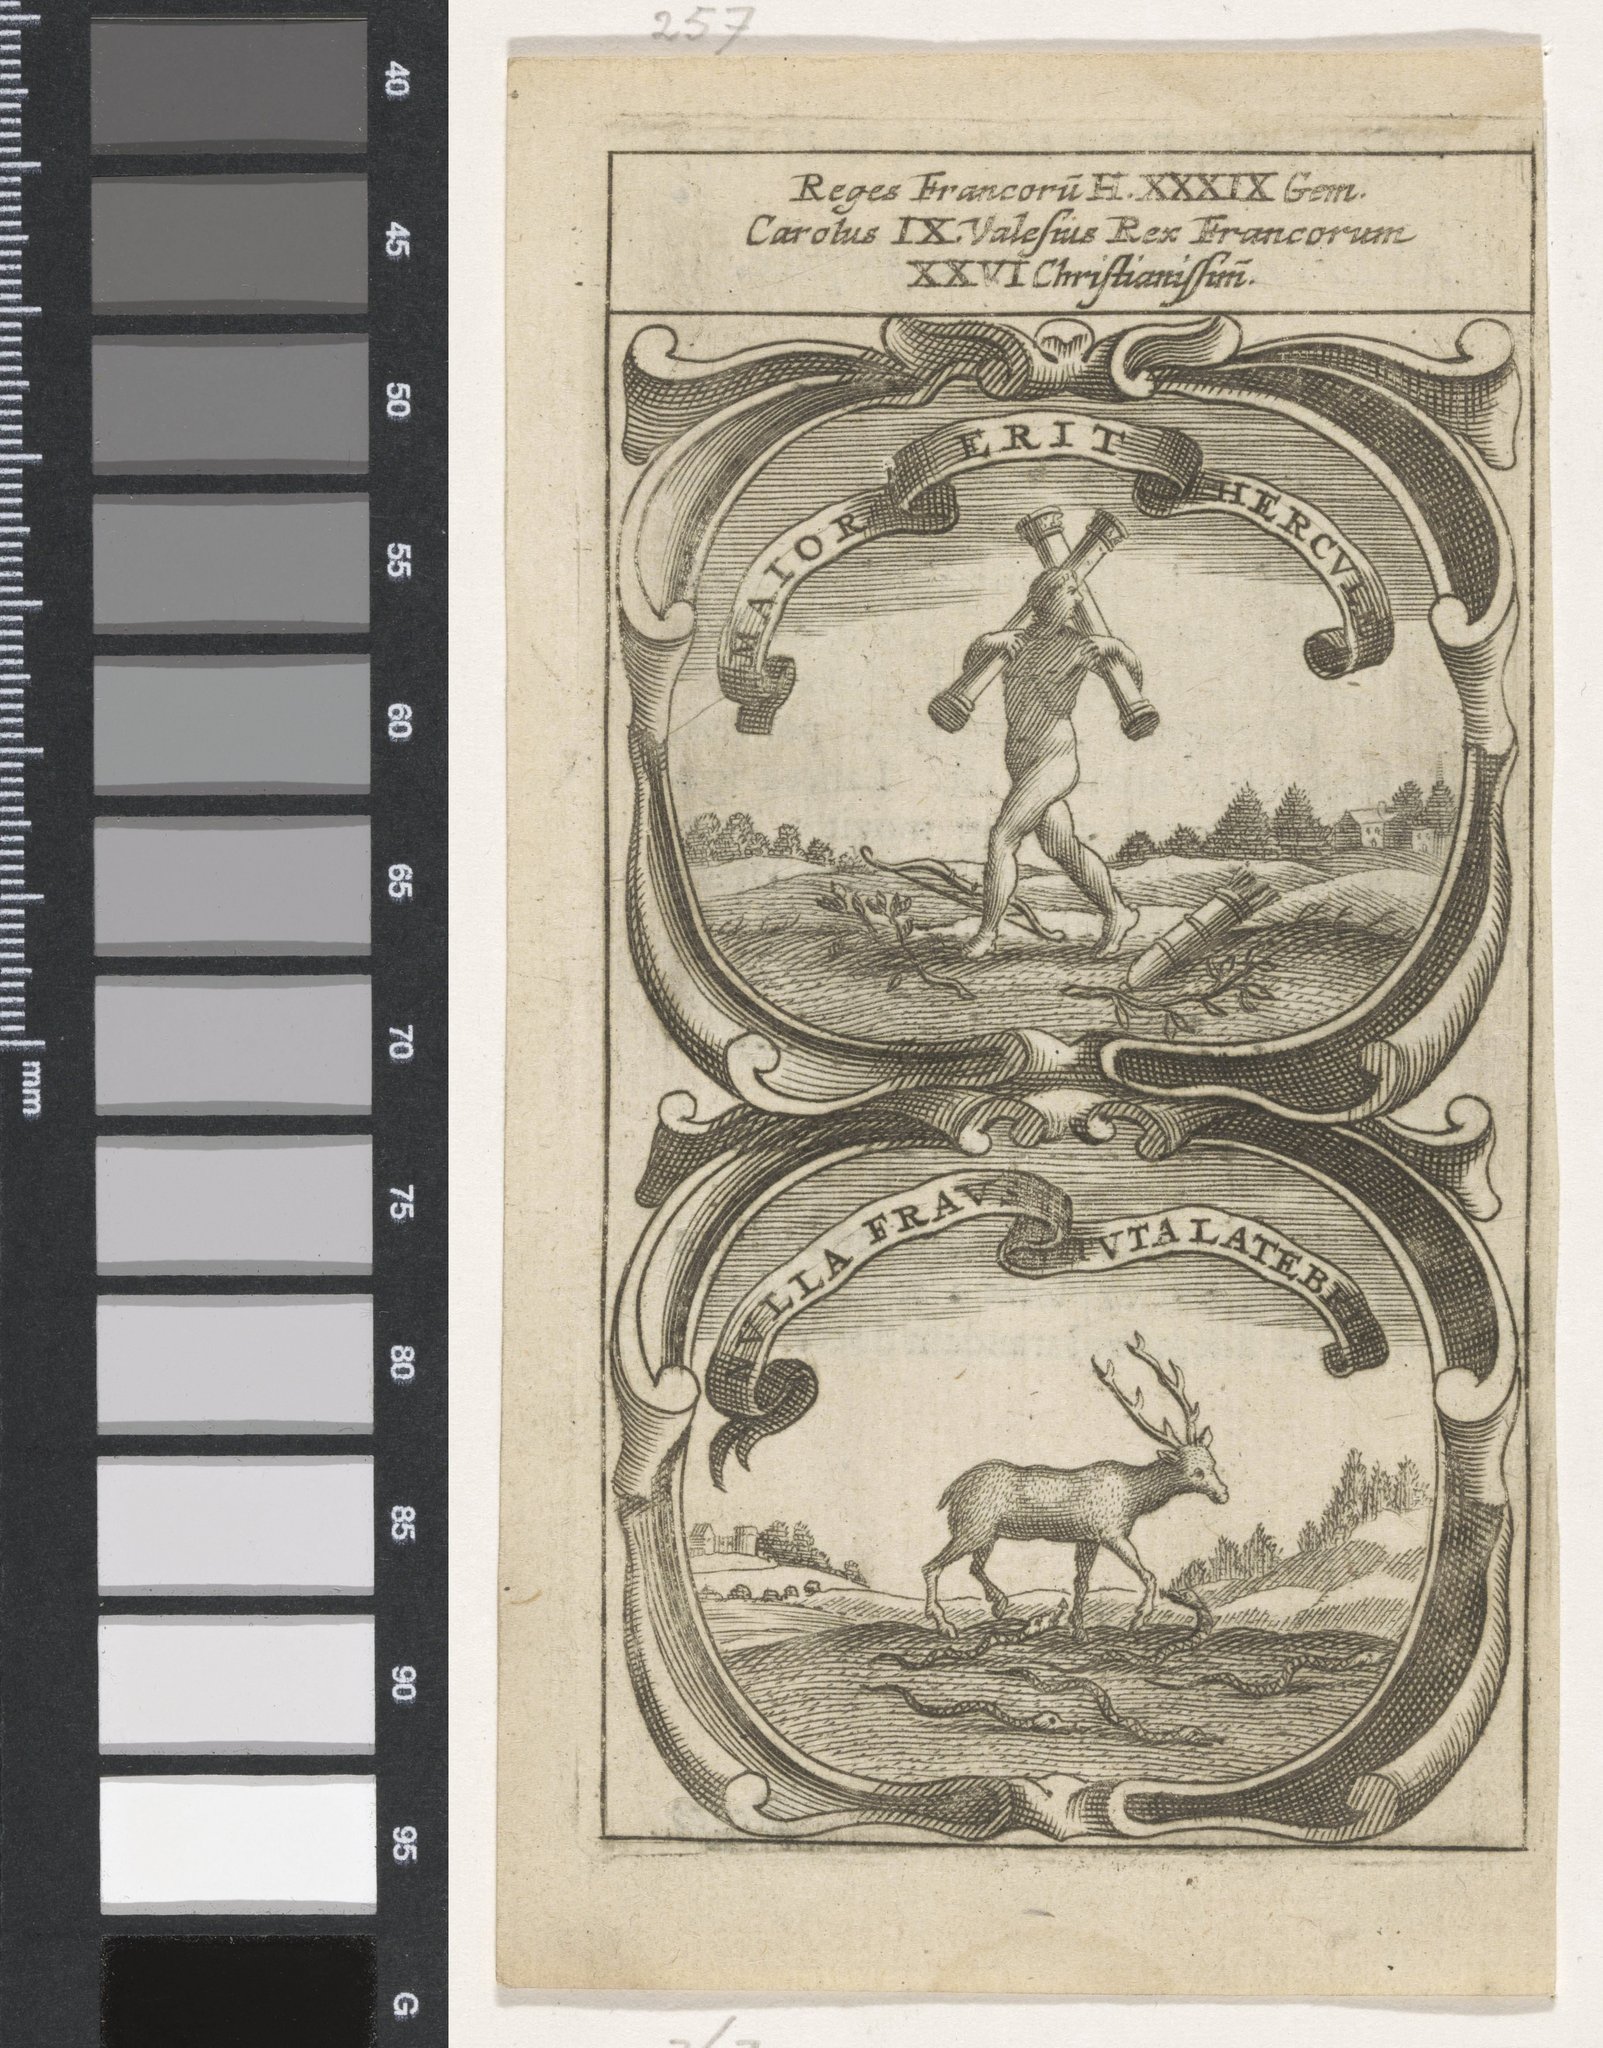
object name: book illustration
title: Man met twee zuilen / Hert tussen de slangen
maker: Anonymous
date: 1666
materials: paper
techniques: engraving, letterpress printing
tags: karel ix (koning van frankrijk), snakes, hoofed animals: deer, column, pillar ~ architecture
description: Een embleem met twee voorstellingen. Boven een naakte man met twee zuilen op zijn schouders. Op de grond ligt een pijl en boog. Onder een landschap met een hert. Slangen bijten naar zijn poten. Het betreffen deviezen van koning Karel IX van Frankrijk.